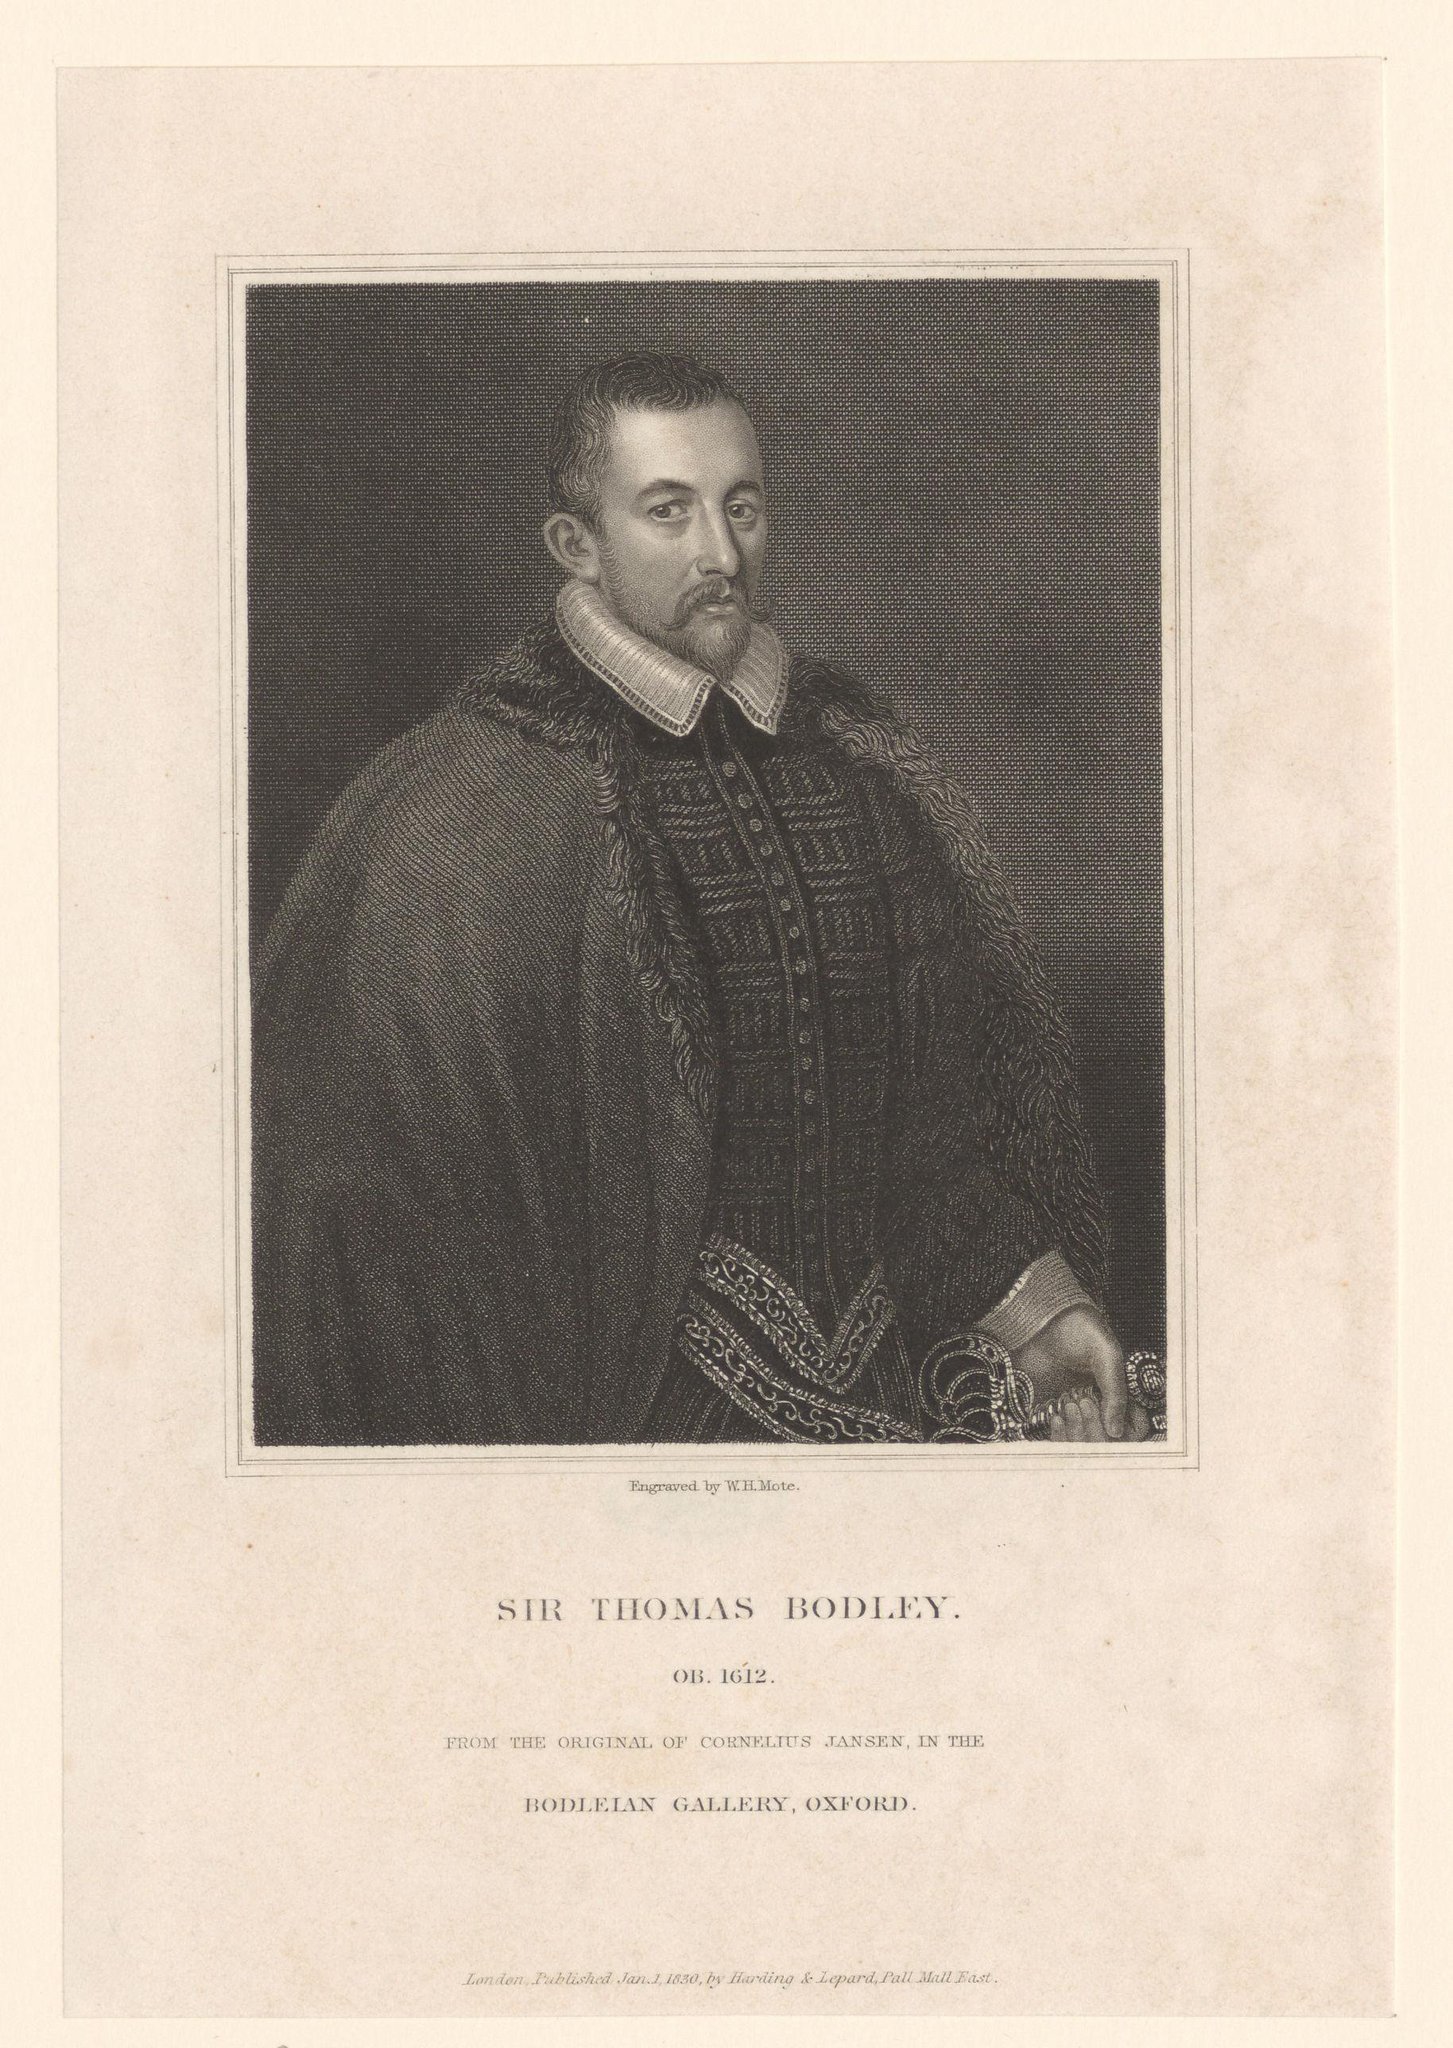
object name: print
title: Sir Thomas Bodley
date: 1830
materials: paper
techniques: engraving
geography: london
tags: historical persons, diplomacy, diplomat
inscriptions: collector's mark: Lugt 2228